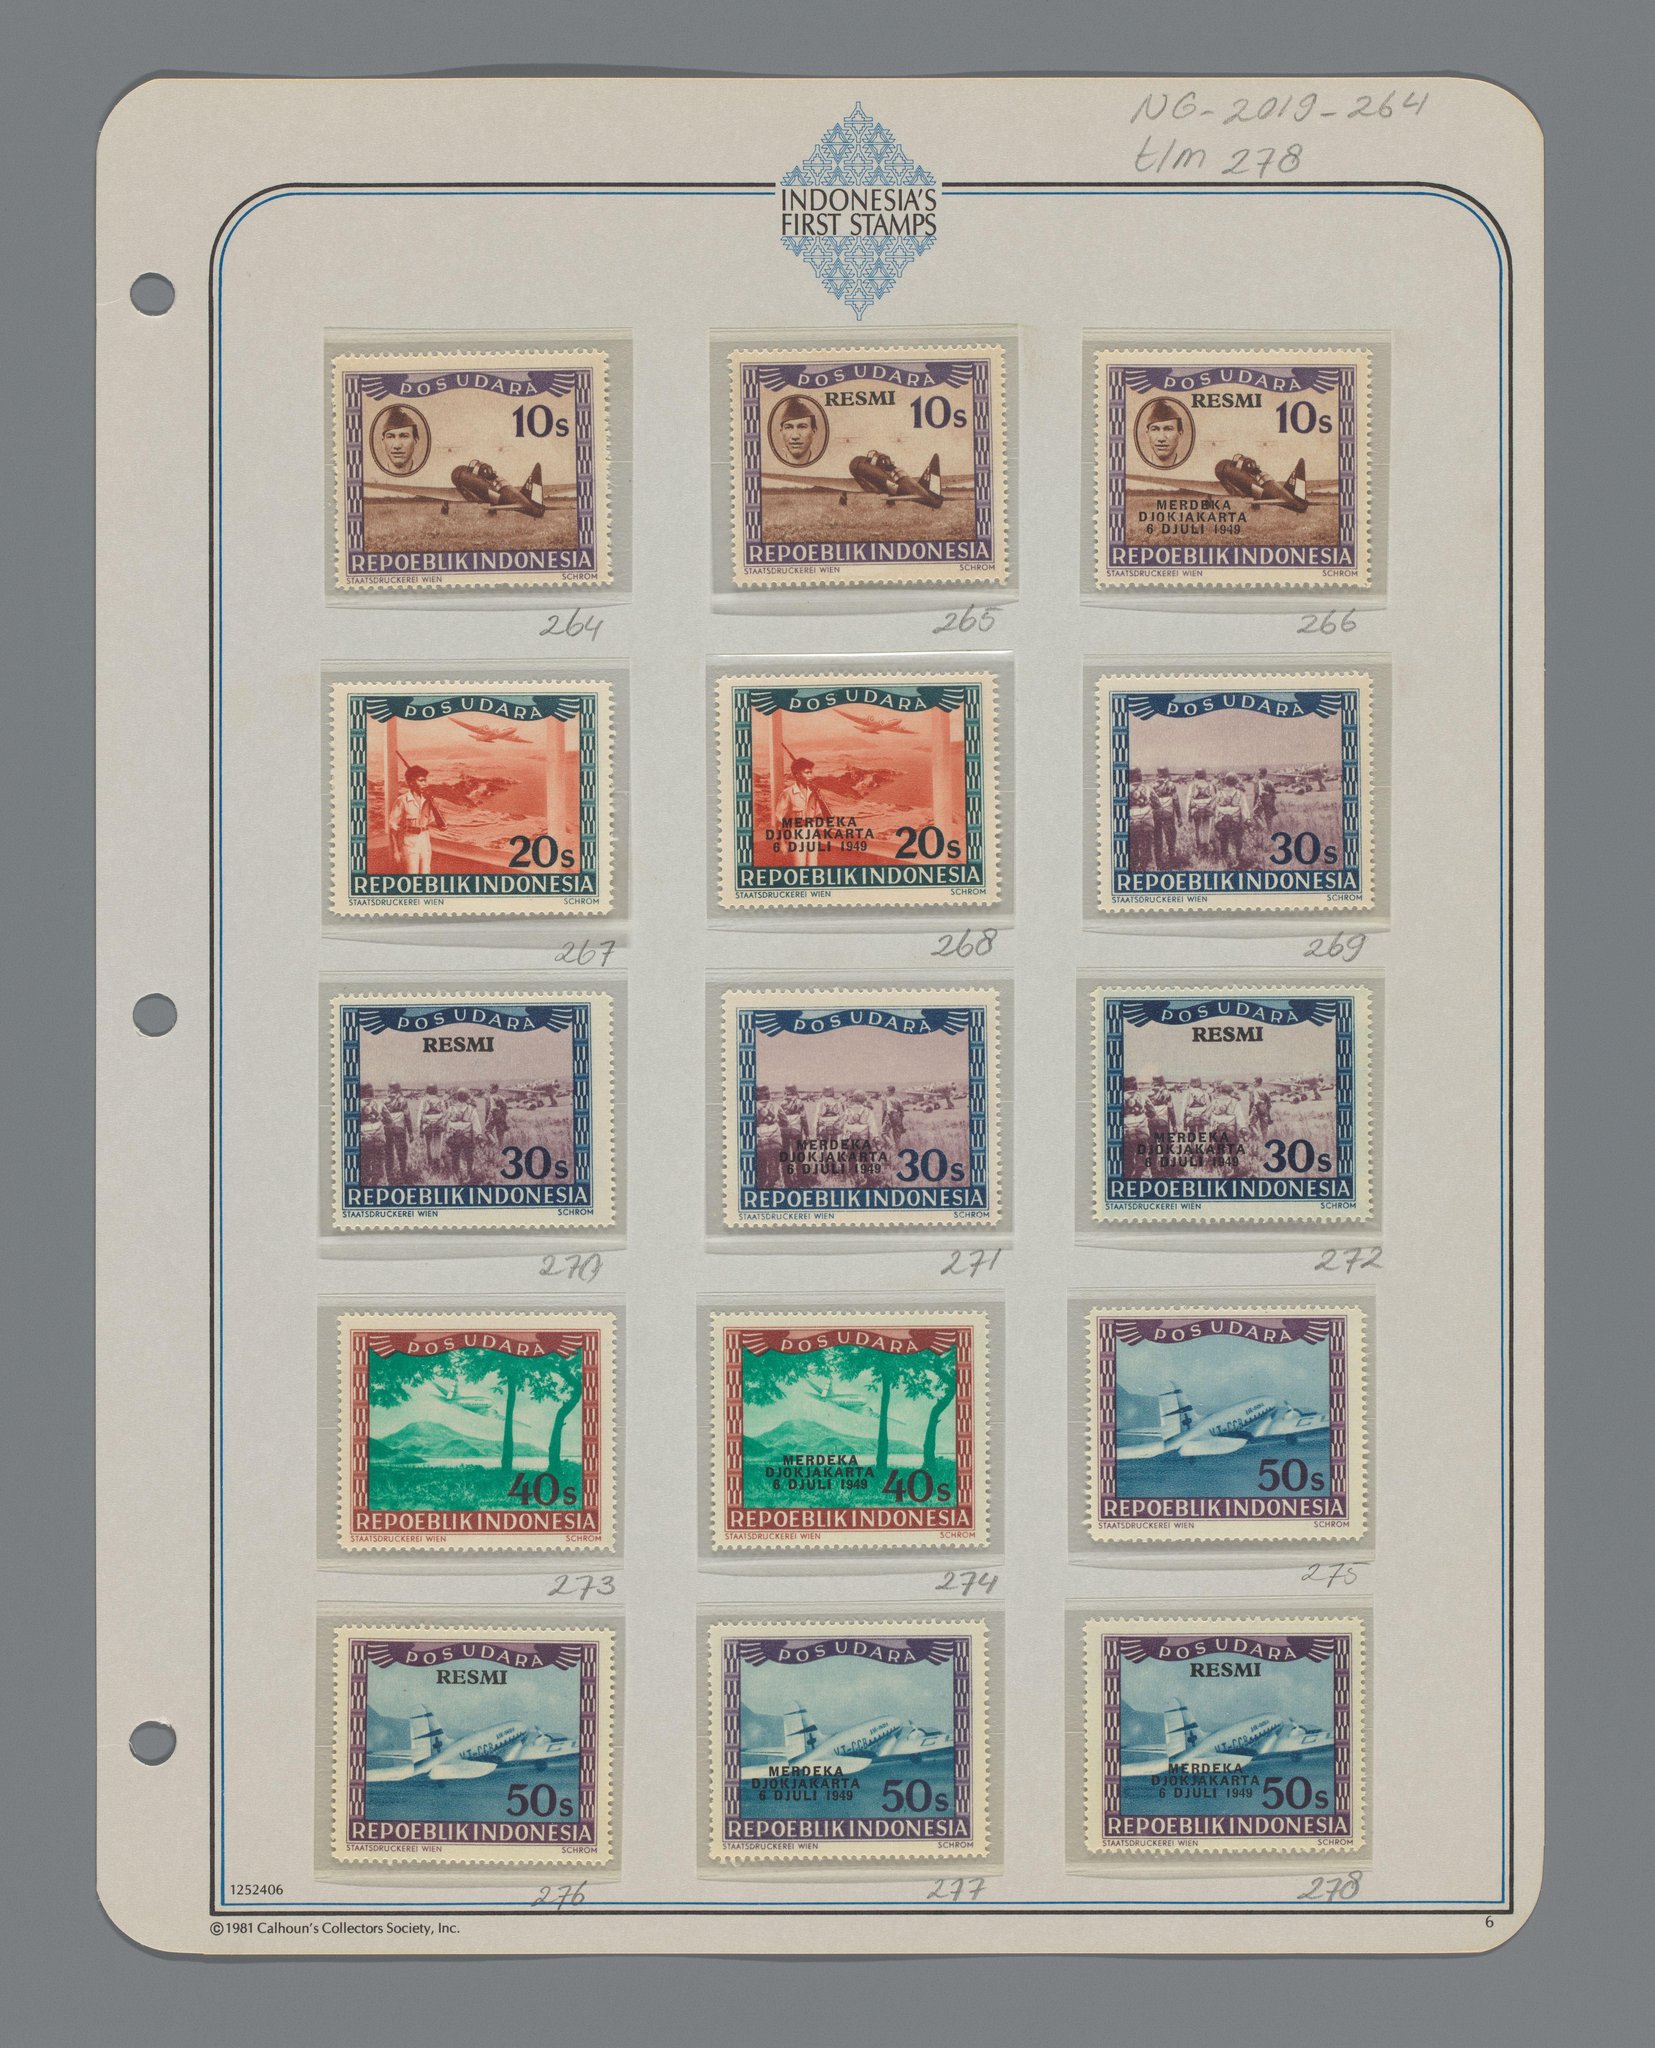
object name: postage stamp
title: Postzegel Republik Indonesia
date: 1949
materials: paper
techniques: photoaquatint, engraving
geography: vienna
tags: indonesia